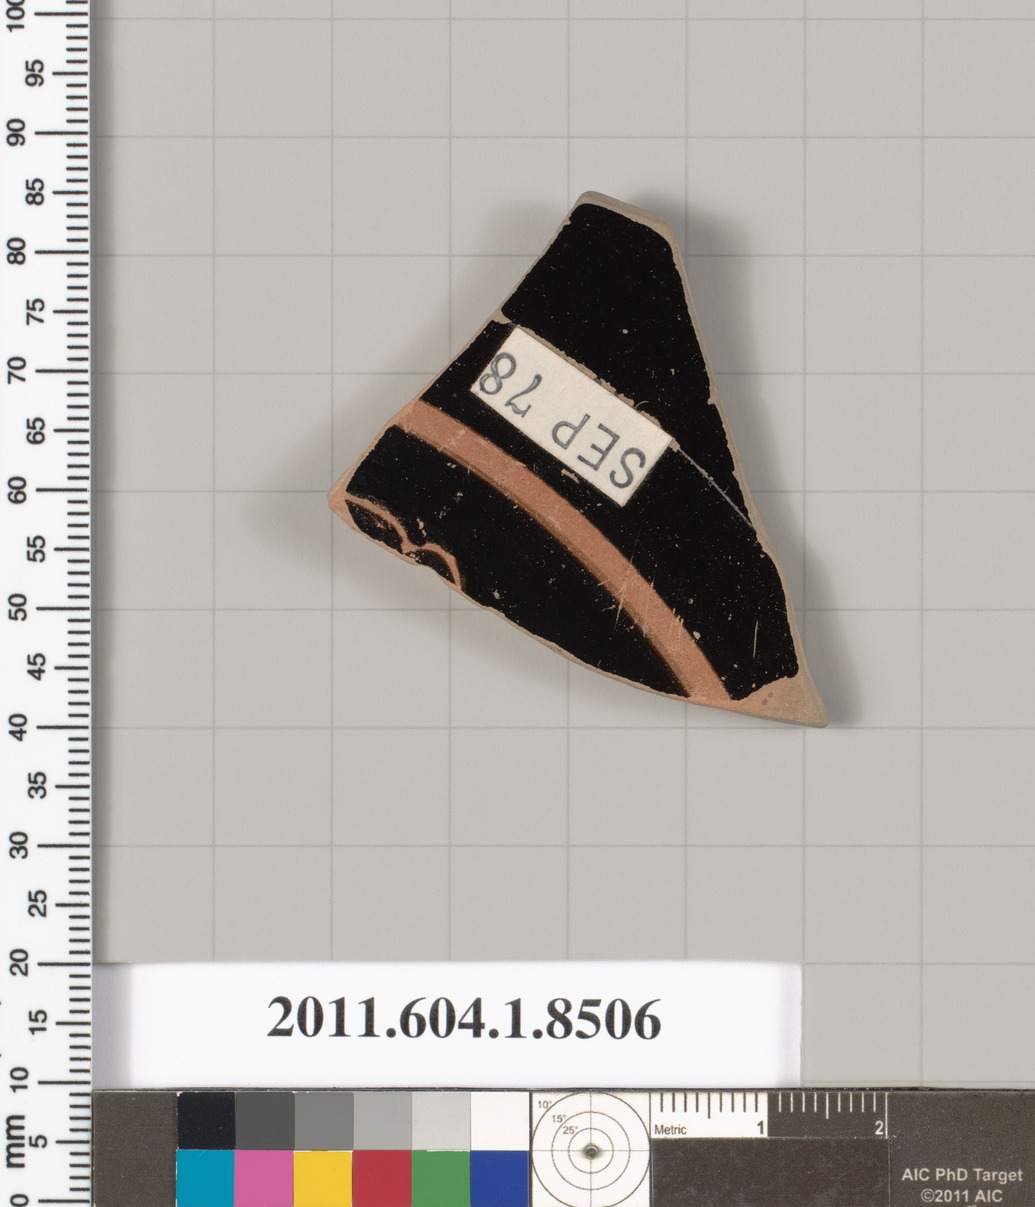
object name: kylix fragment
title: Terracotta fragment of a stemless kylix (drinking cup)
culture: greek, attic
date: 470-450 BCE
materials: terracotta